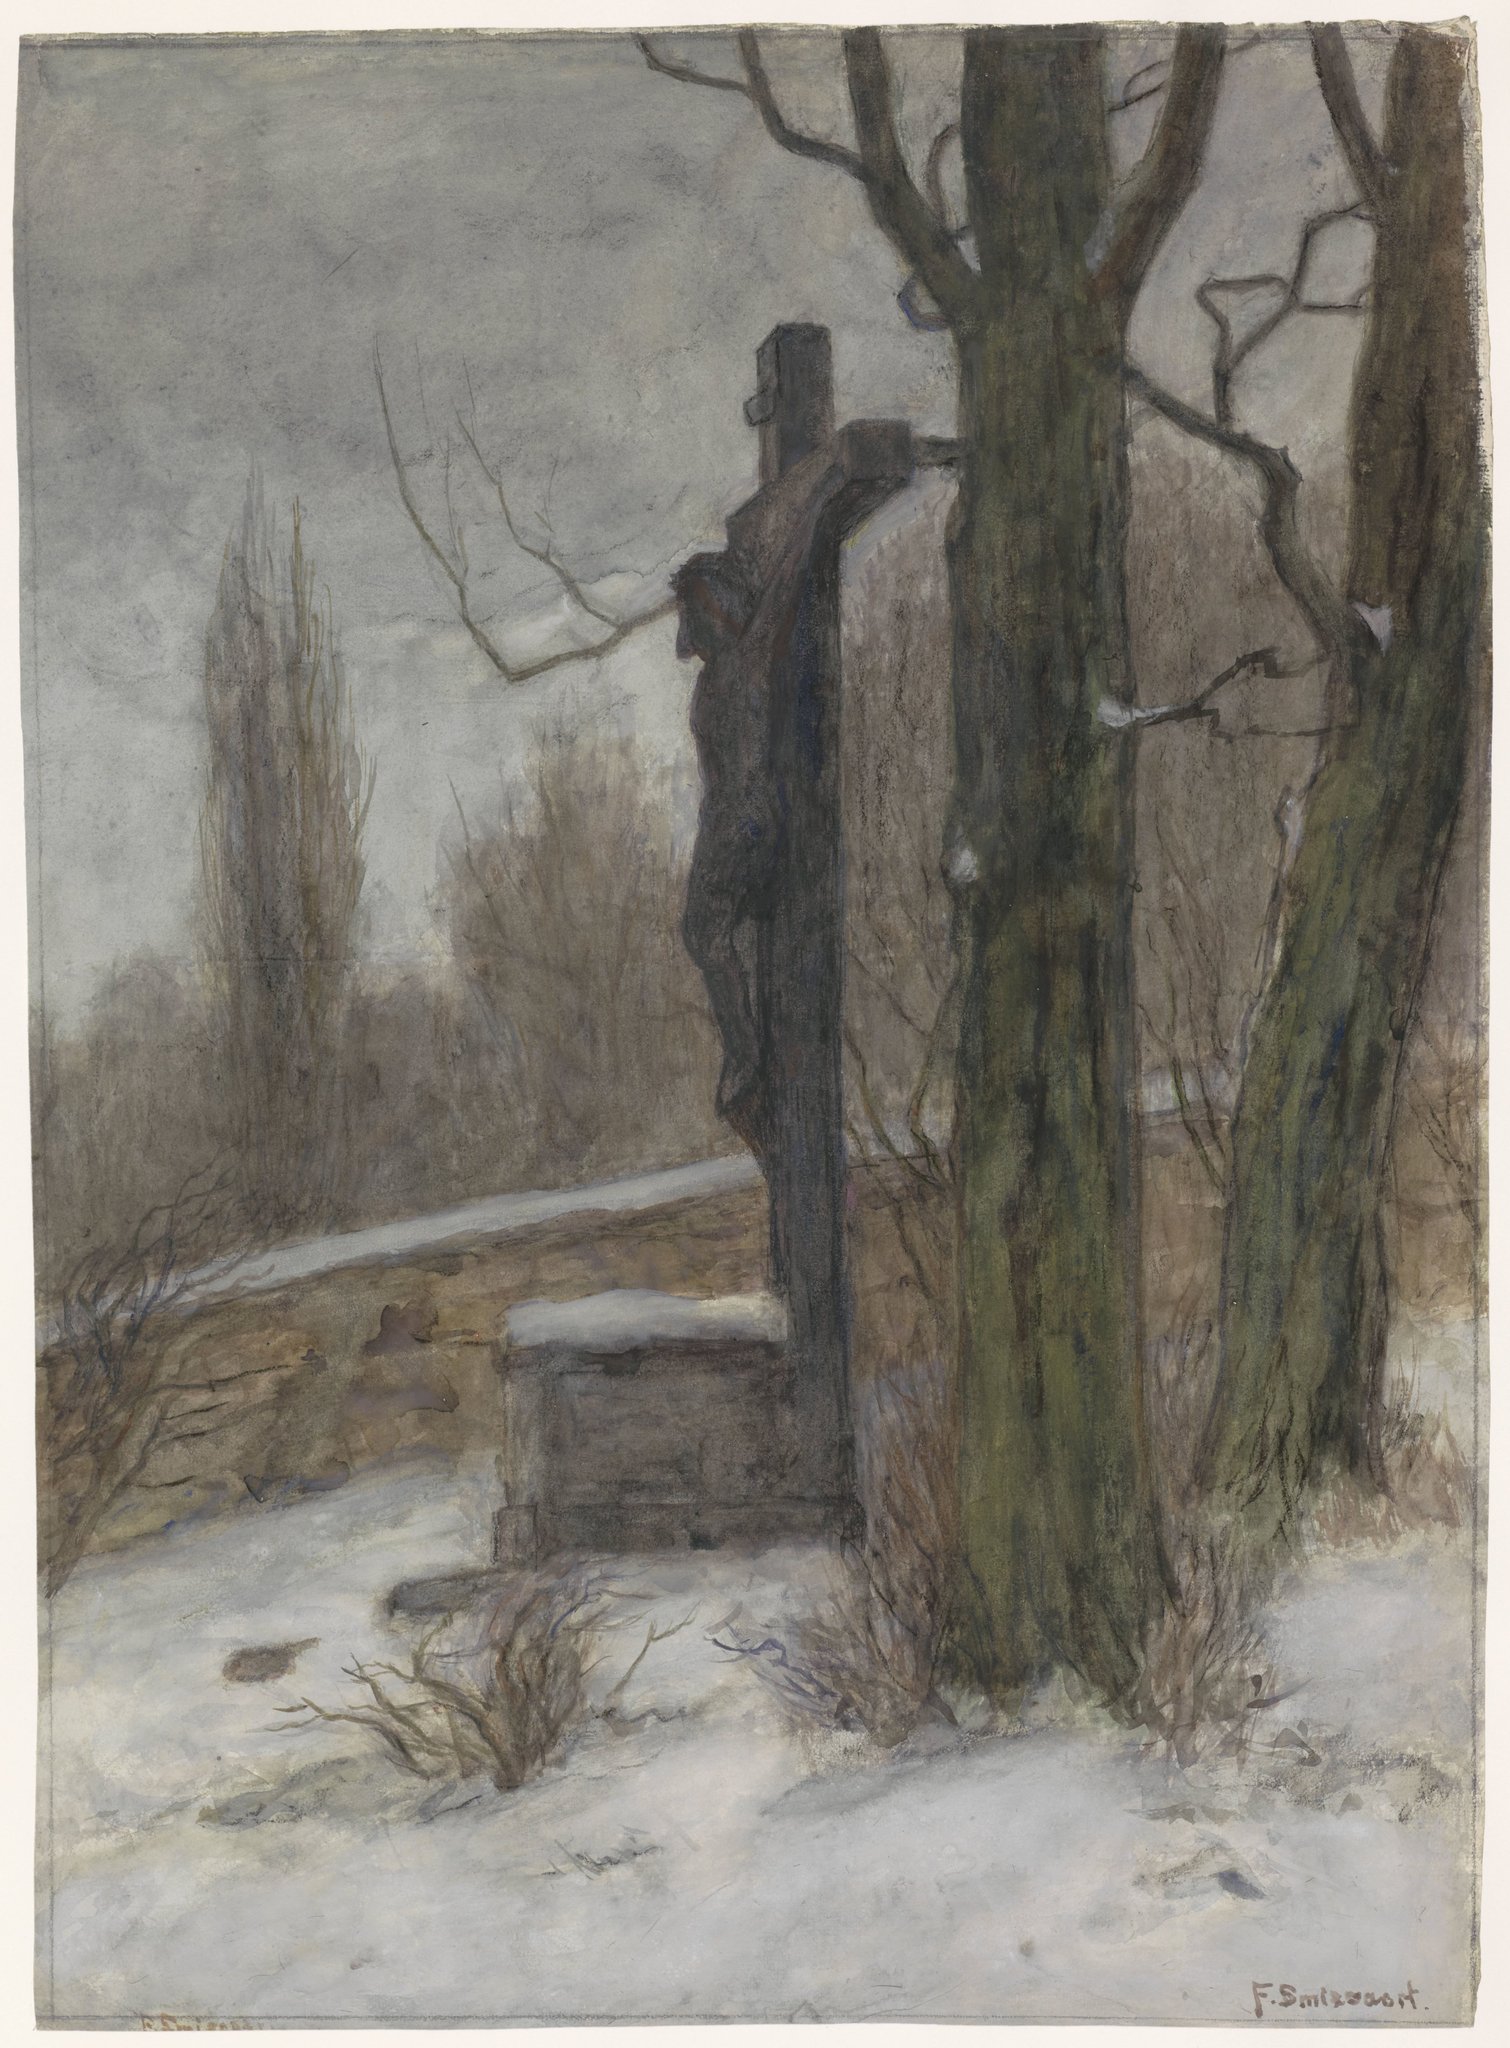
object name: drawing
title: Kruisbeeld in een besneeuwd bos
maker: frans smissaert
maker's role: draughtsman, print maker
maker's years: 1862-1944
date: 1872-1944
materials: chalk, paper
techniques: brush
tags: forest, wood, crucifix ~ personal devotion, snow